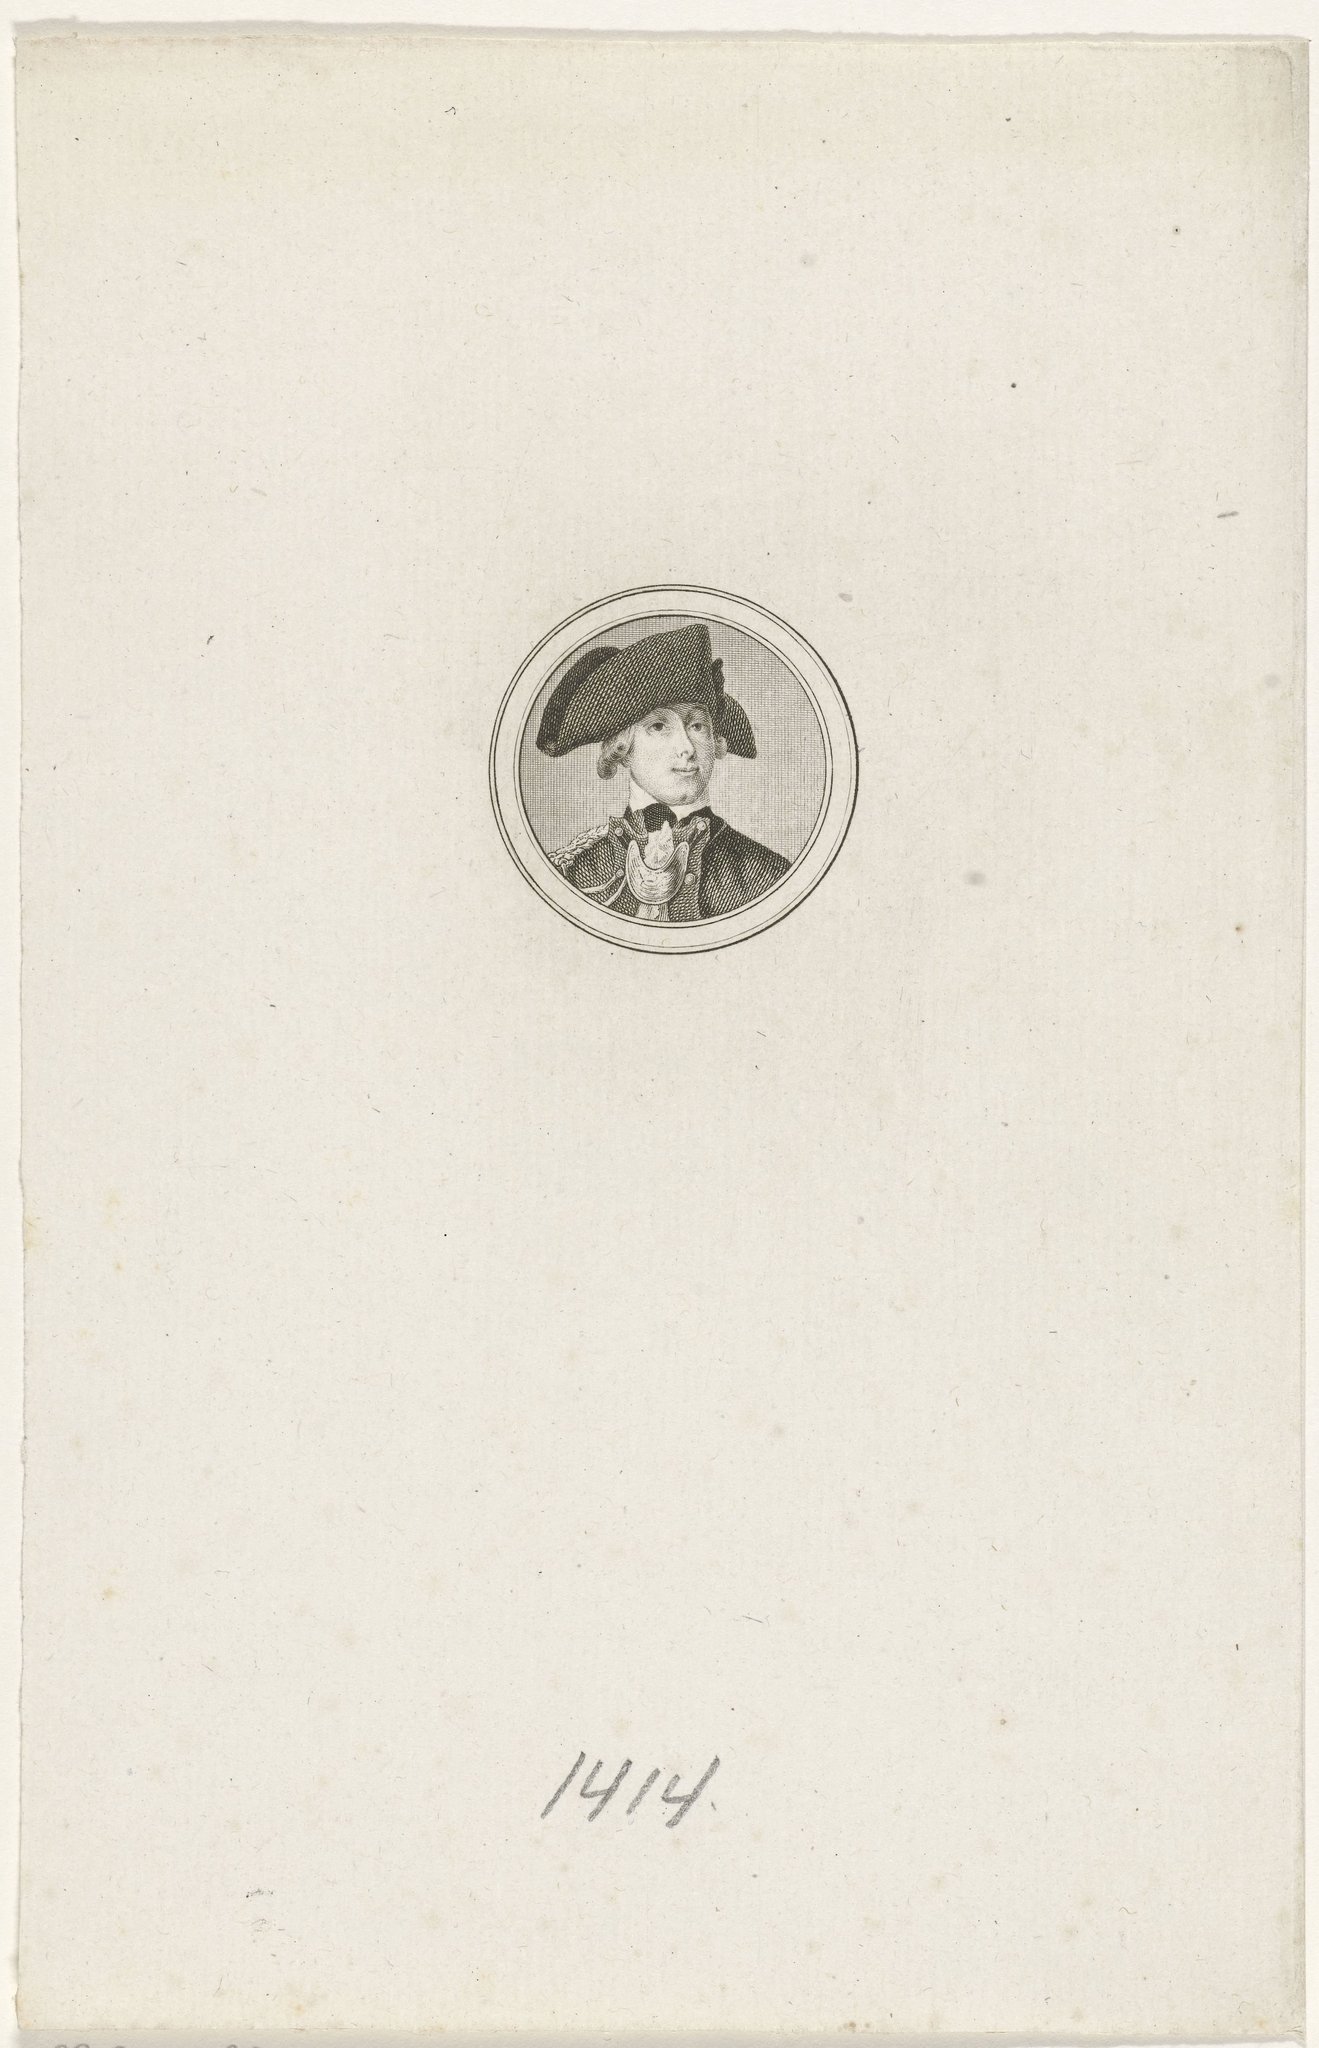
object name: print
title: Portretten van patriotten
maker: abraham jacobsz. hulk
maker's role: print maker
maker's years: 1751-1817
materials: paper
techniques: engraving, etching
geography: paris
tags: kapitein, abraham valentijn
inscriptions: collector's mark: Lugt 2228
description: Buste van Abraham Valentijn naar rechts in een medaillon. Valentijn draagt een steekhoed.